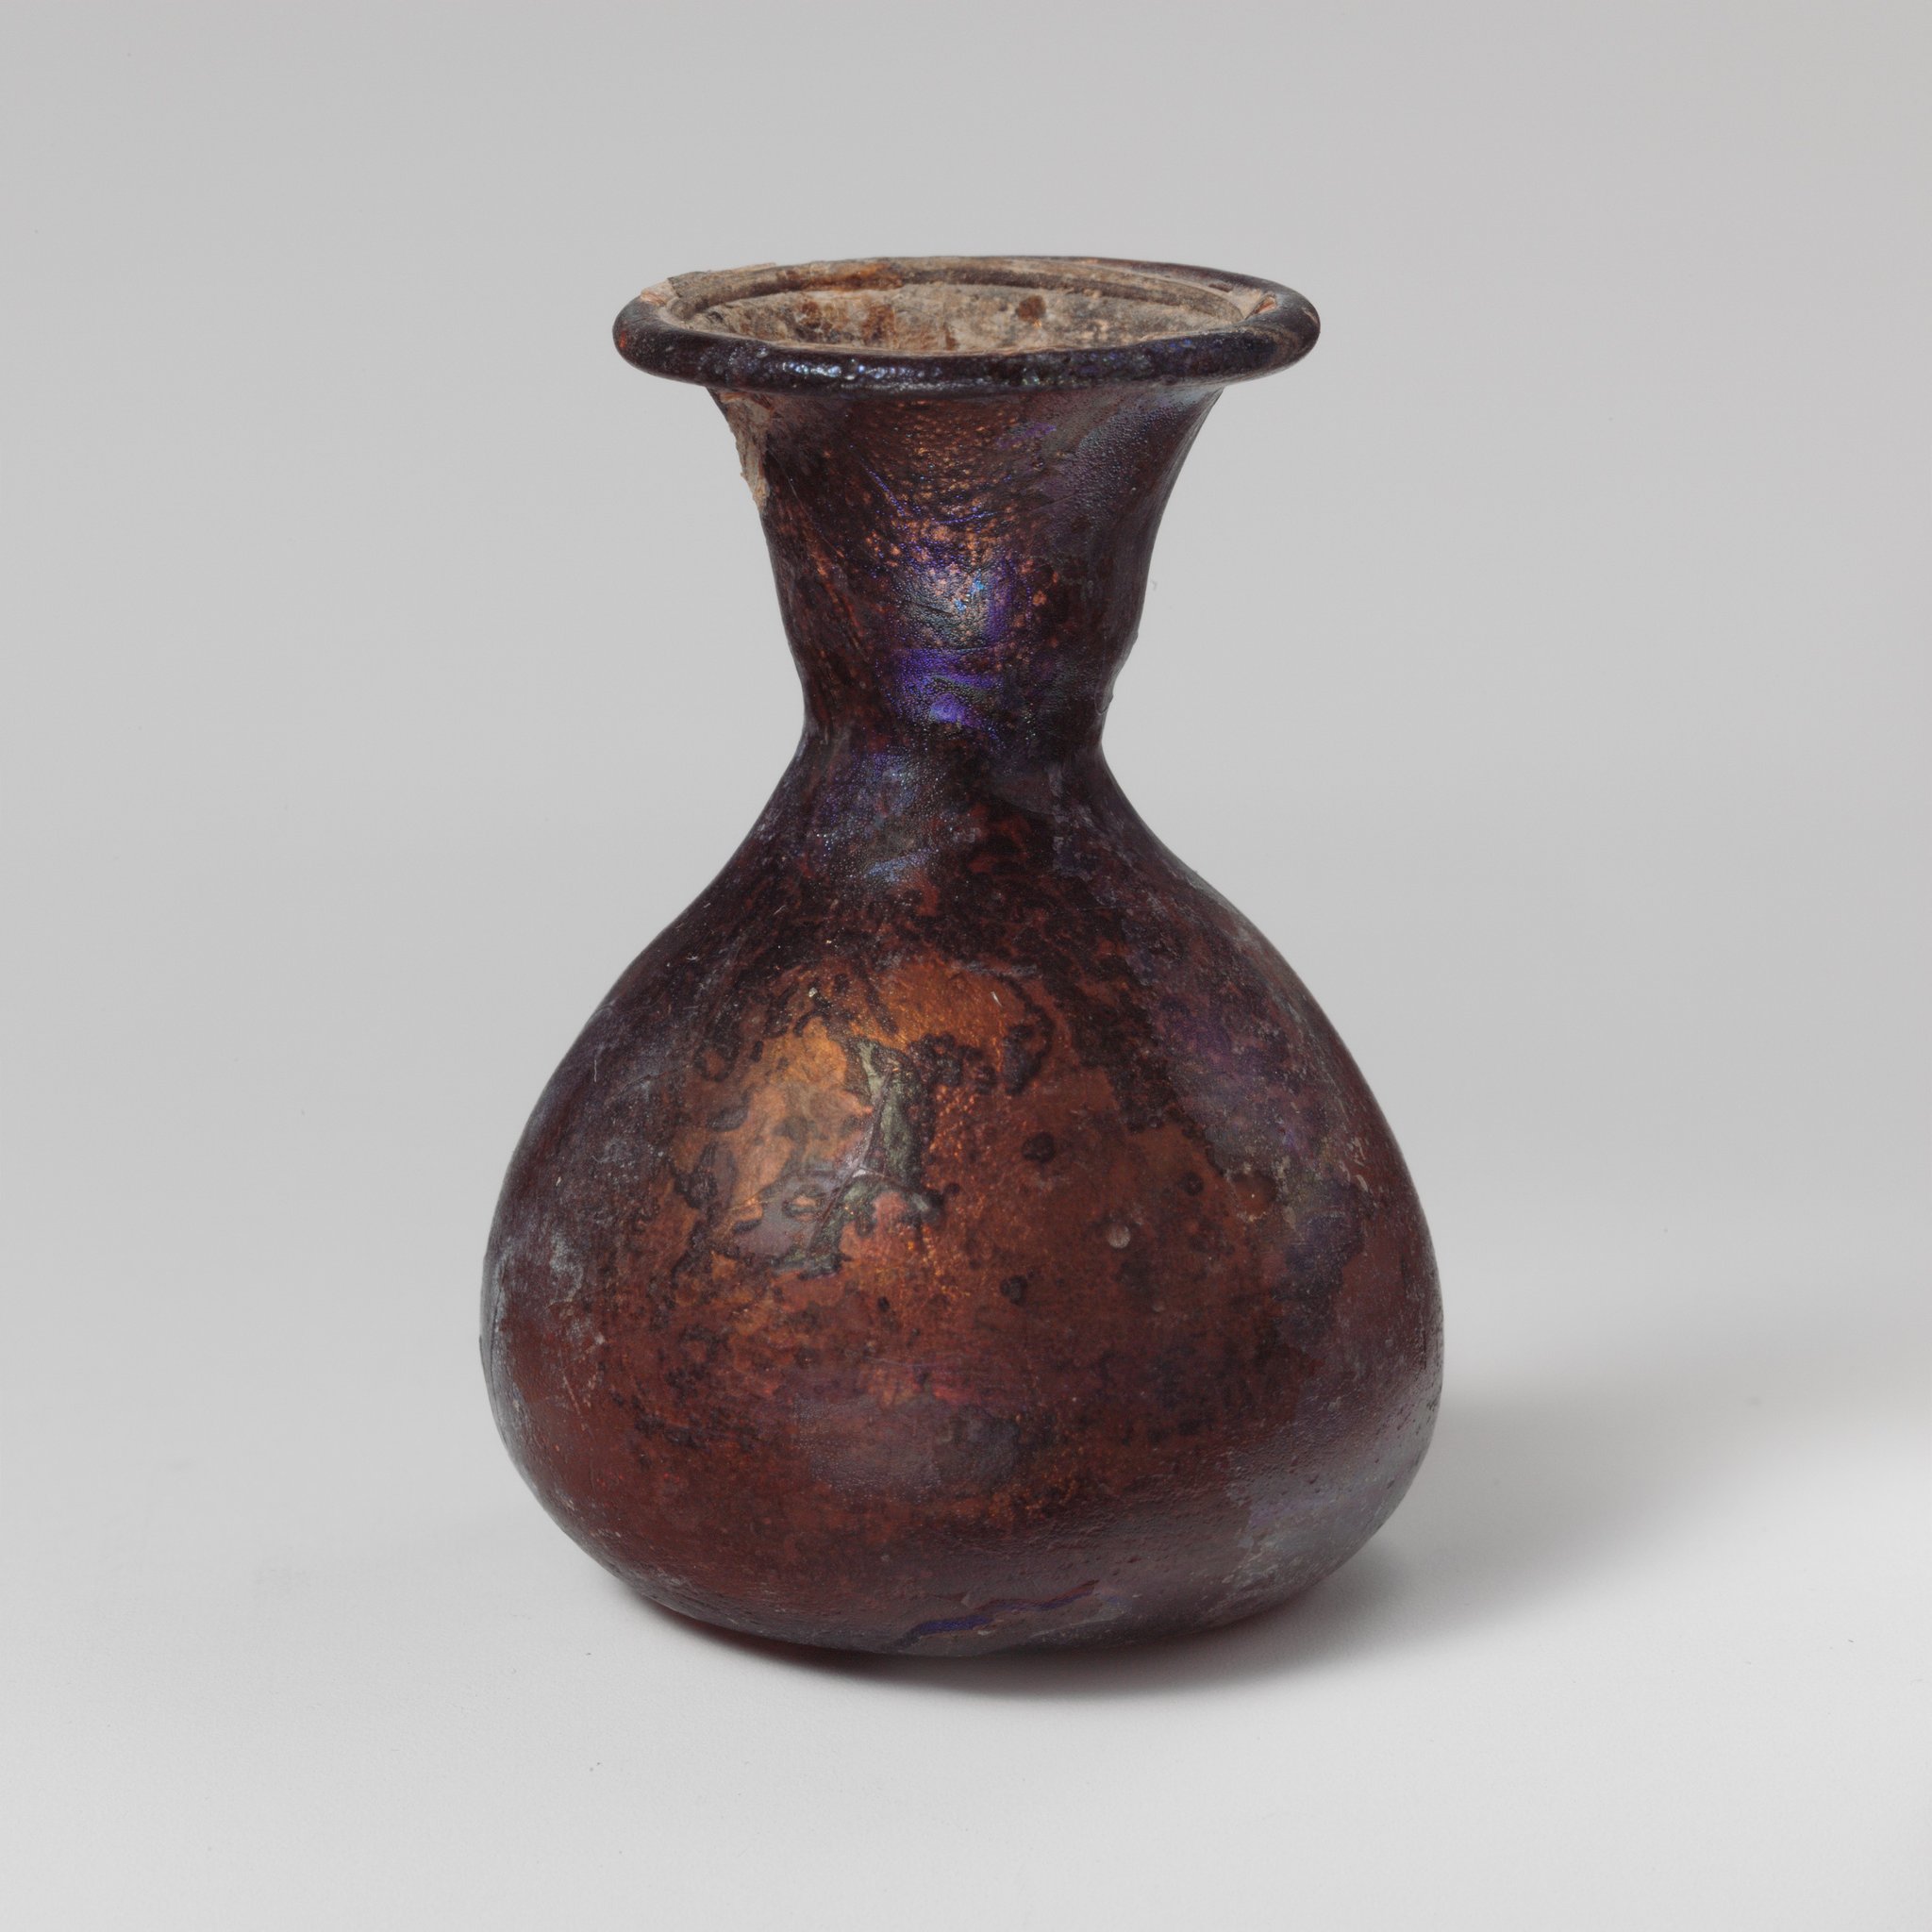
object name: perfume bottle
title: Glass perfume bottle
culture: roman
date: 201-400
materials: glass